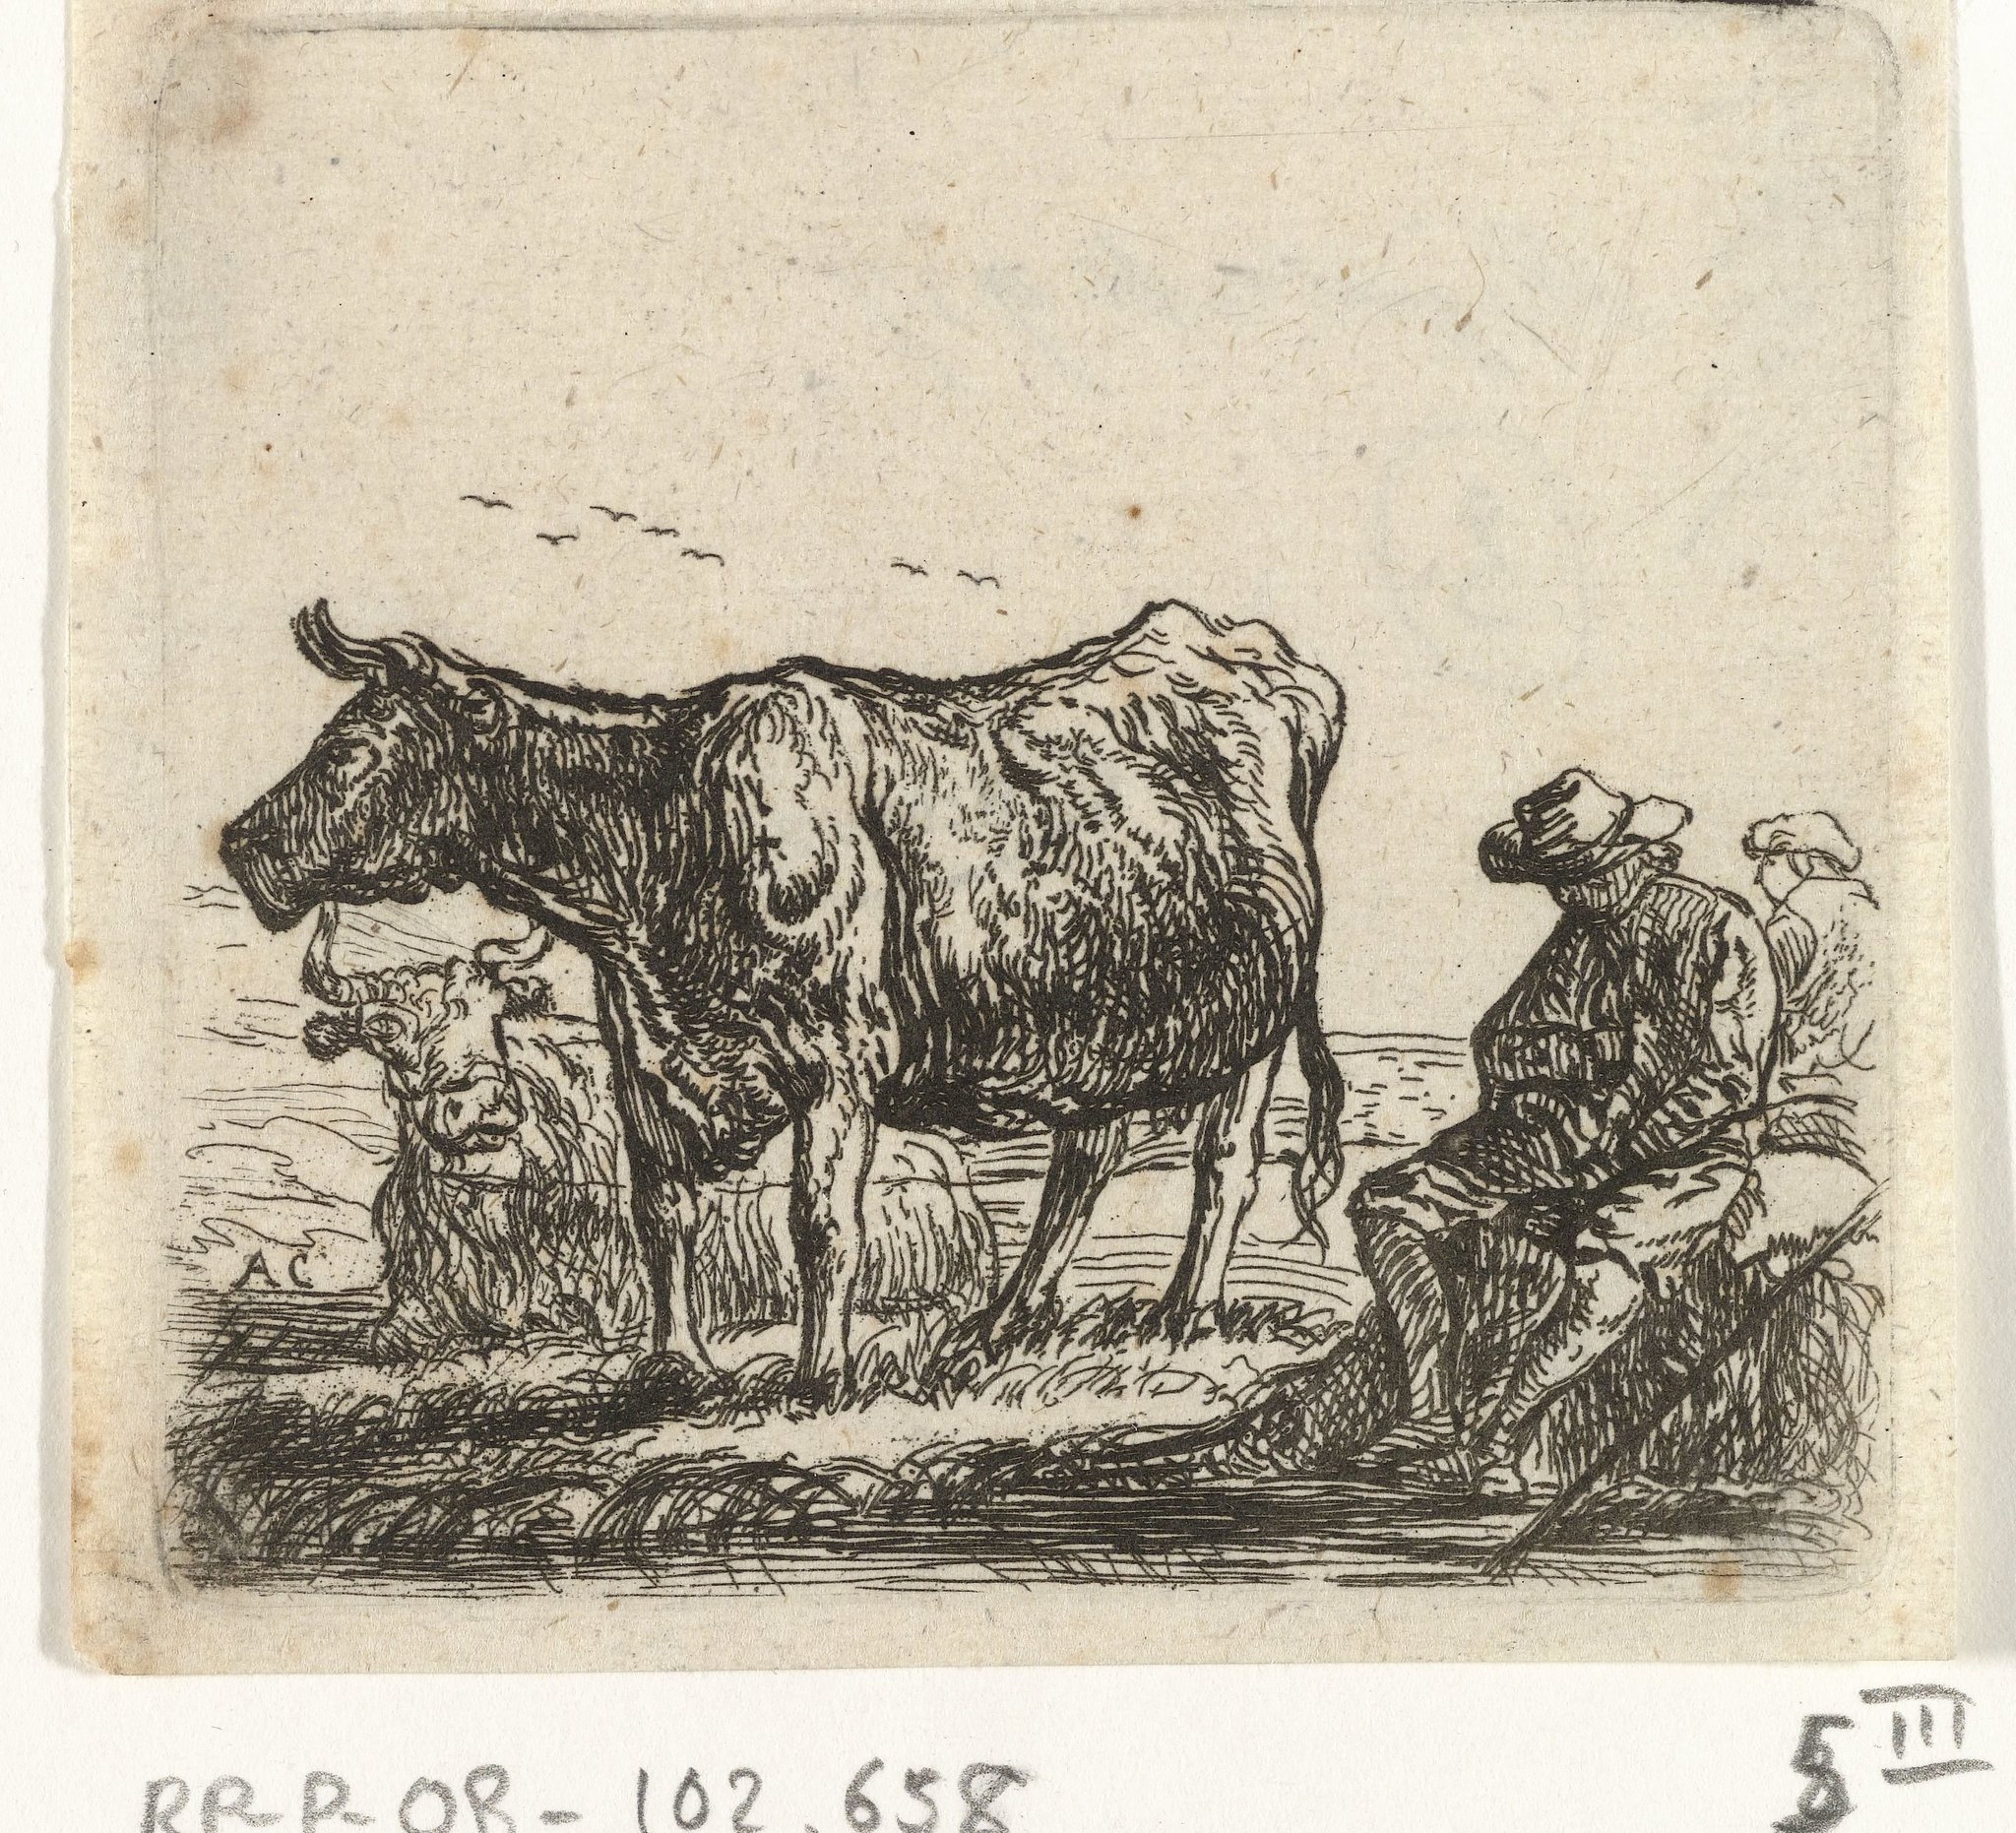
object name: print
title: Twee koeien en herders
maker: Anonymous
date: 1630-1691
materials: paper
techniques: etching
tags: cow, herding, herdsman, herdswoman, shepherd, shepherdess, cowherd, etc.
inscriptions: collector's mark: Lugt 2228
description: Prent uit serie van zes prenten met koeien. Bij de derde staat werd door een anonieme vervaardiger een titelprent aan de serie toegevoegd.